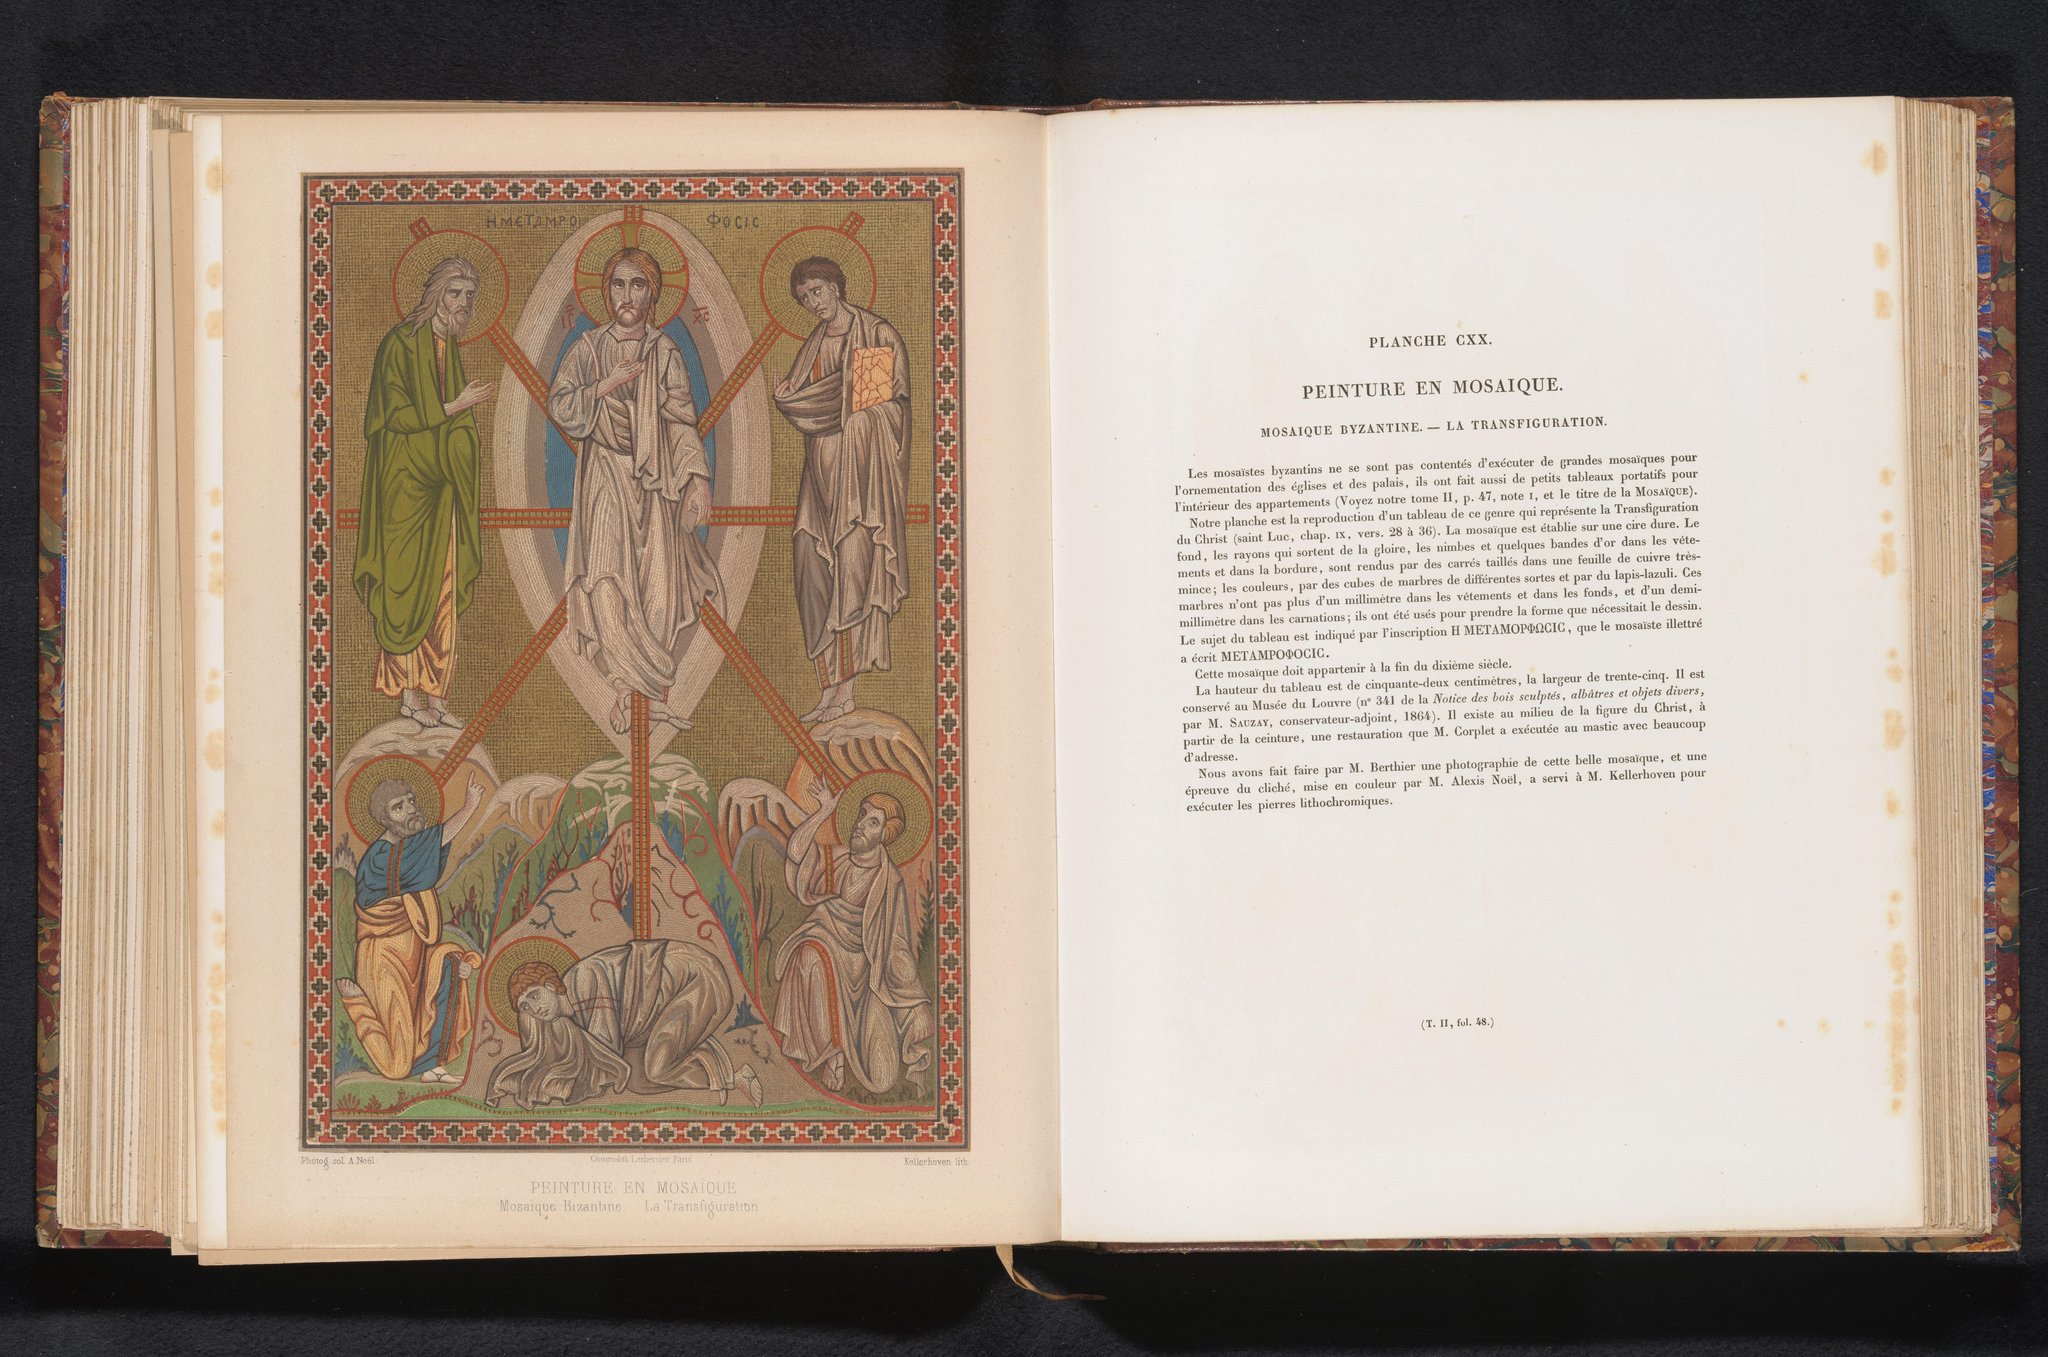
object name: reproduction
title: Reproductie van een ontwerp van de transfiguratie van Christus in mozaïek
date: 1859-1864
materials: paper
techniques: photolithography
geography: paris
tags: the transfiguration: moses and elijah appear on either side of christ on mount tabor (matthew 17:1-13; mark 9:2-13; luke 9:28-36)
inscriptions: name: ‘Photog. col. A. Noël./ Kellerhoven lith.’